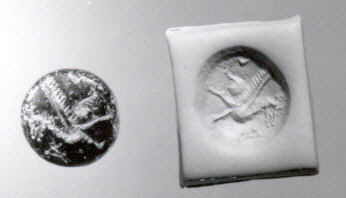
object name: stamp cylinder seal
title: Stamp-cylinder seal (with loop handle) with monsters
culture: urartian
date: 800-601 BCE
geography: urartu